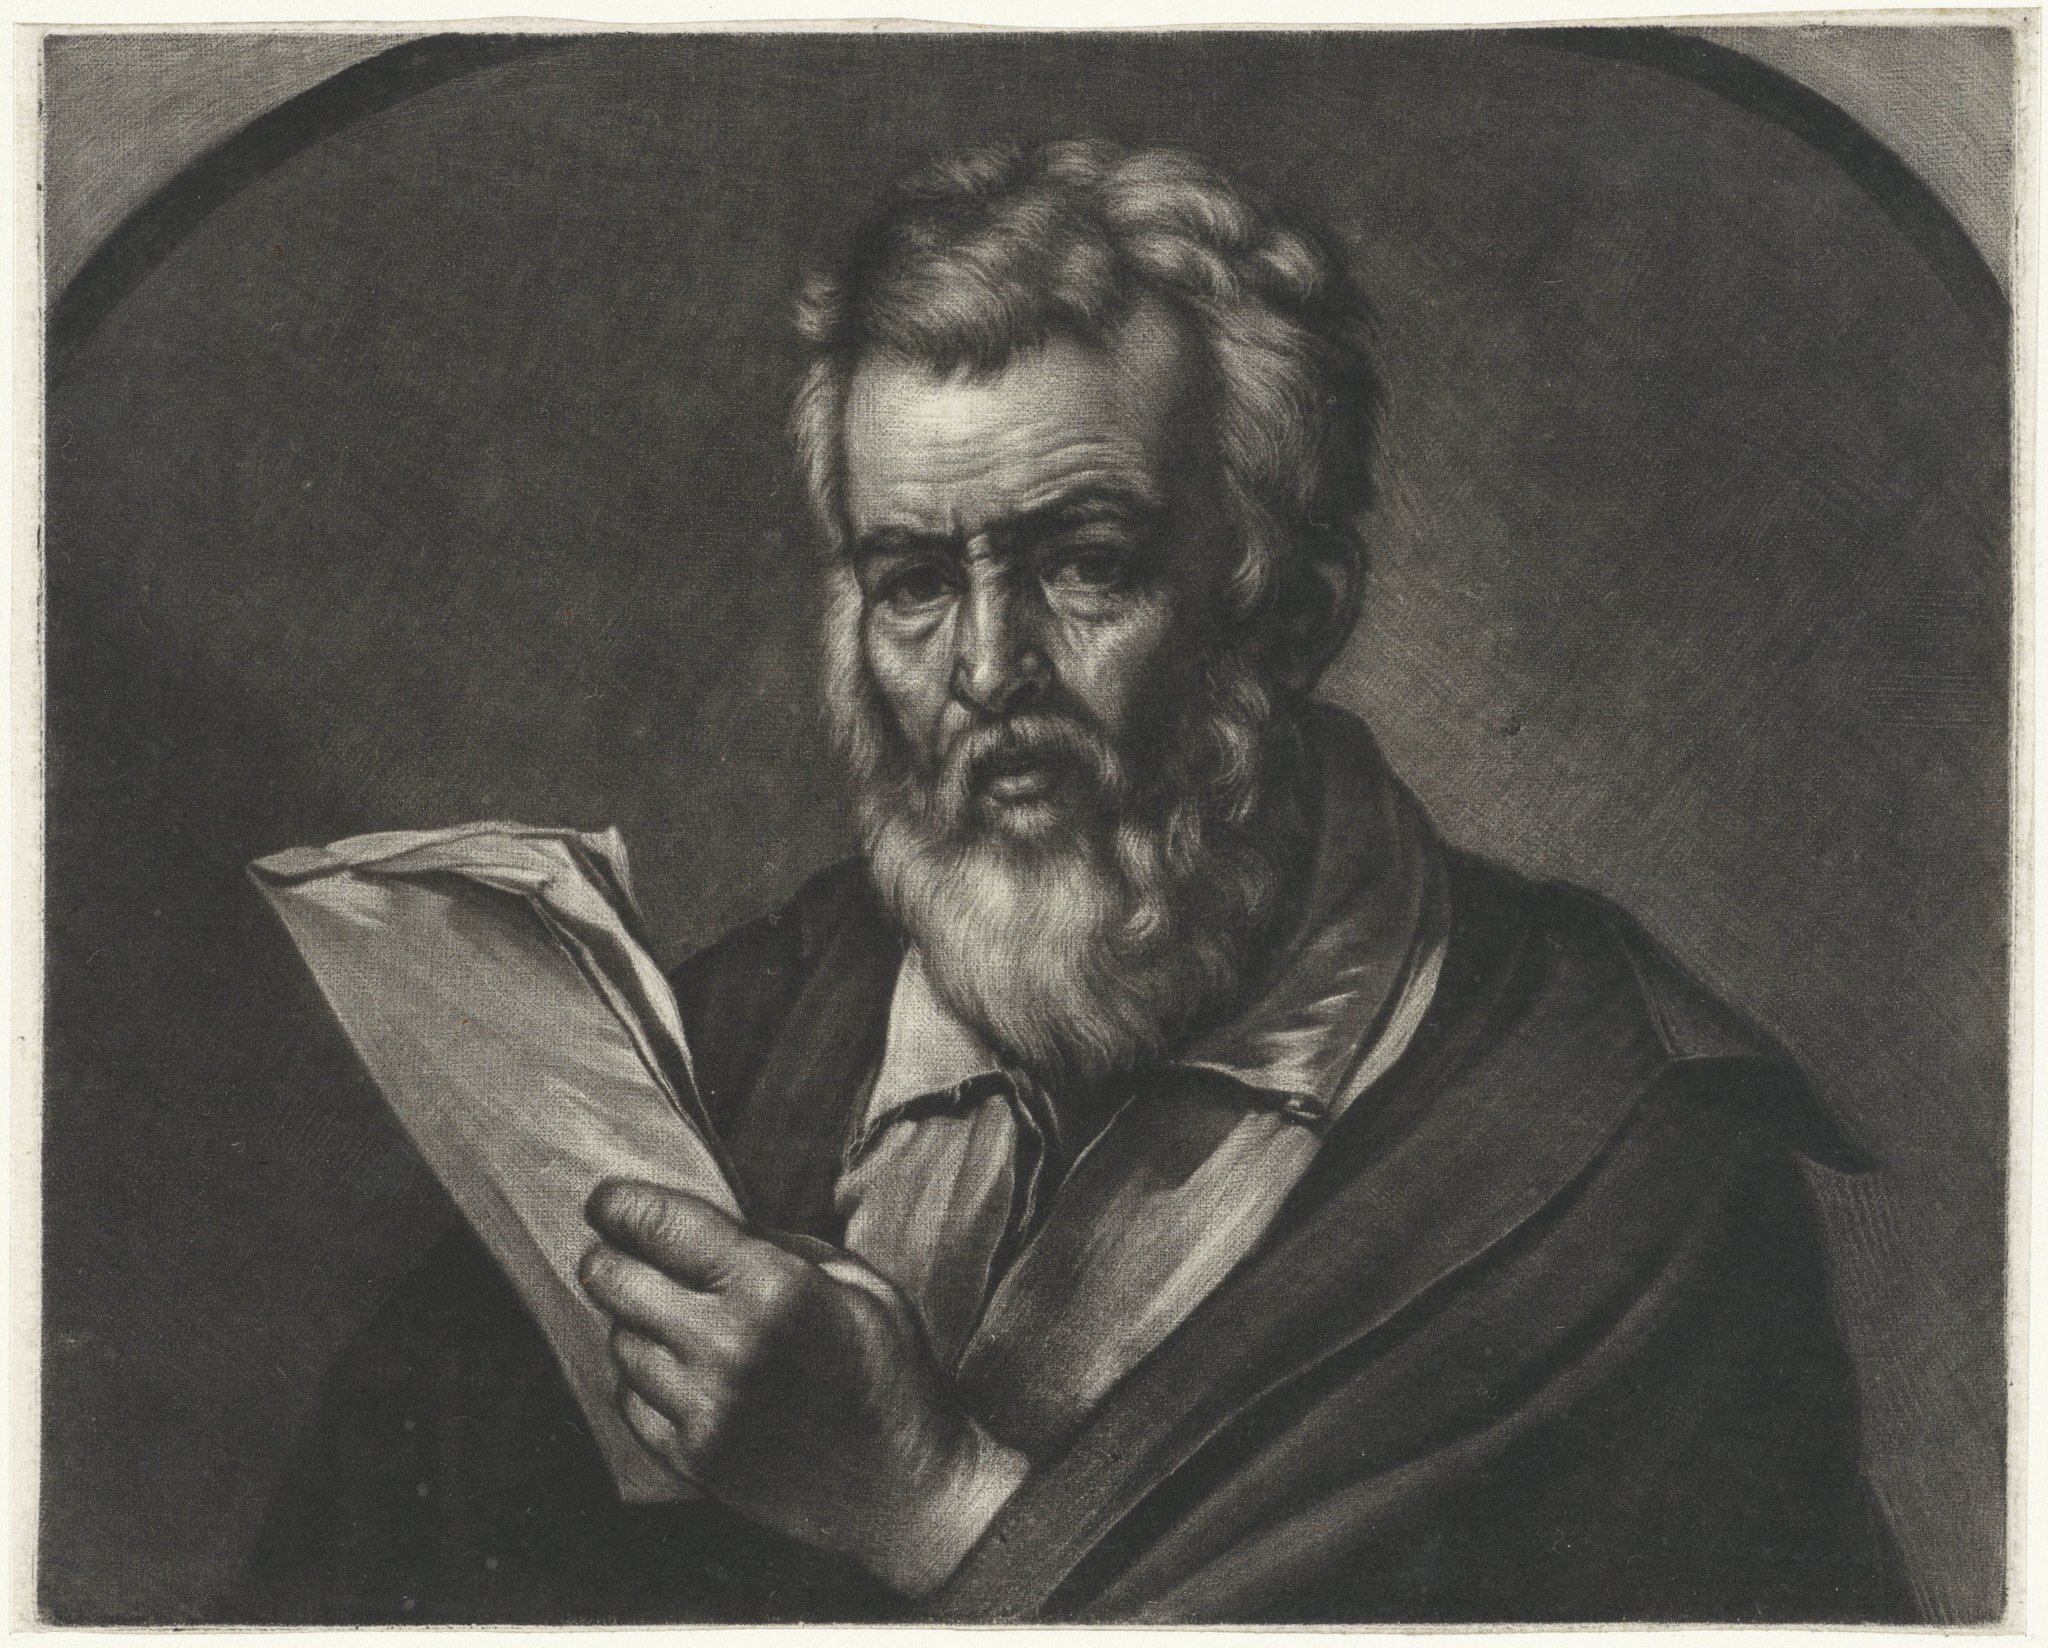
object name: print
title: Man met een boekje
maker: wallerant vaillant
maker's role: draughtsman, painter, print maker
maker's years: 1623-1677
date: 1658-1677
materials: paper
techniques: mezzotint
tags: book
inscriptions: collector's mark: Lugt 240